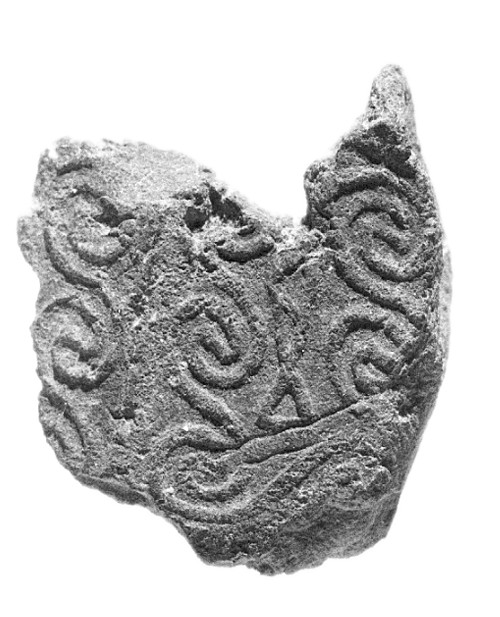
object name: sealing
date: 1981-1640 BCE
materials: mud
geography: egypt